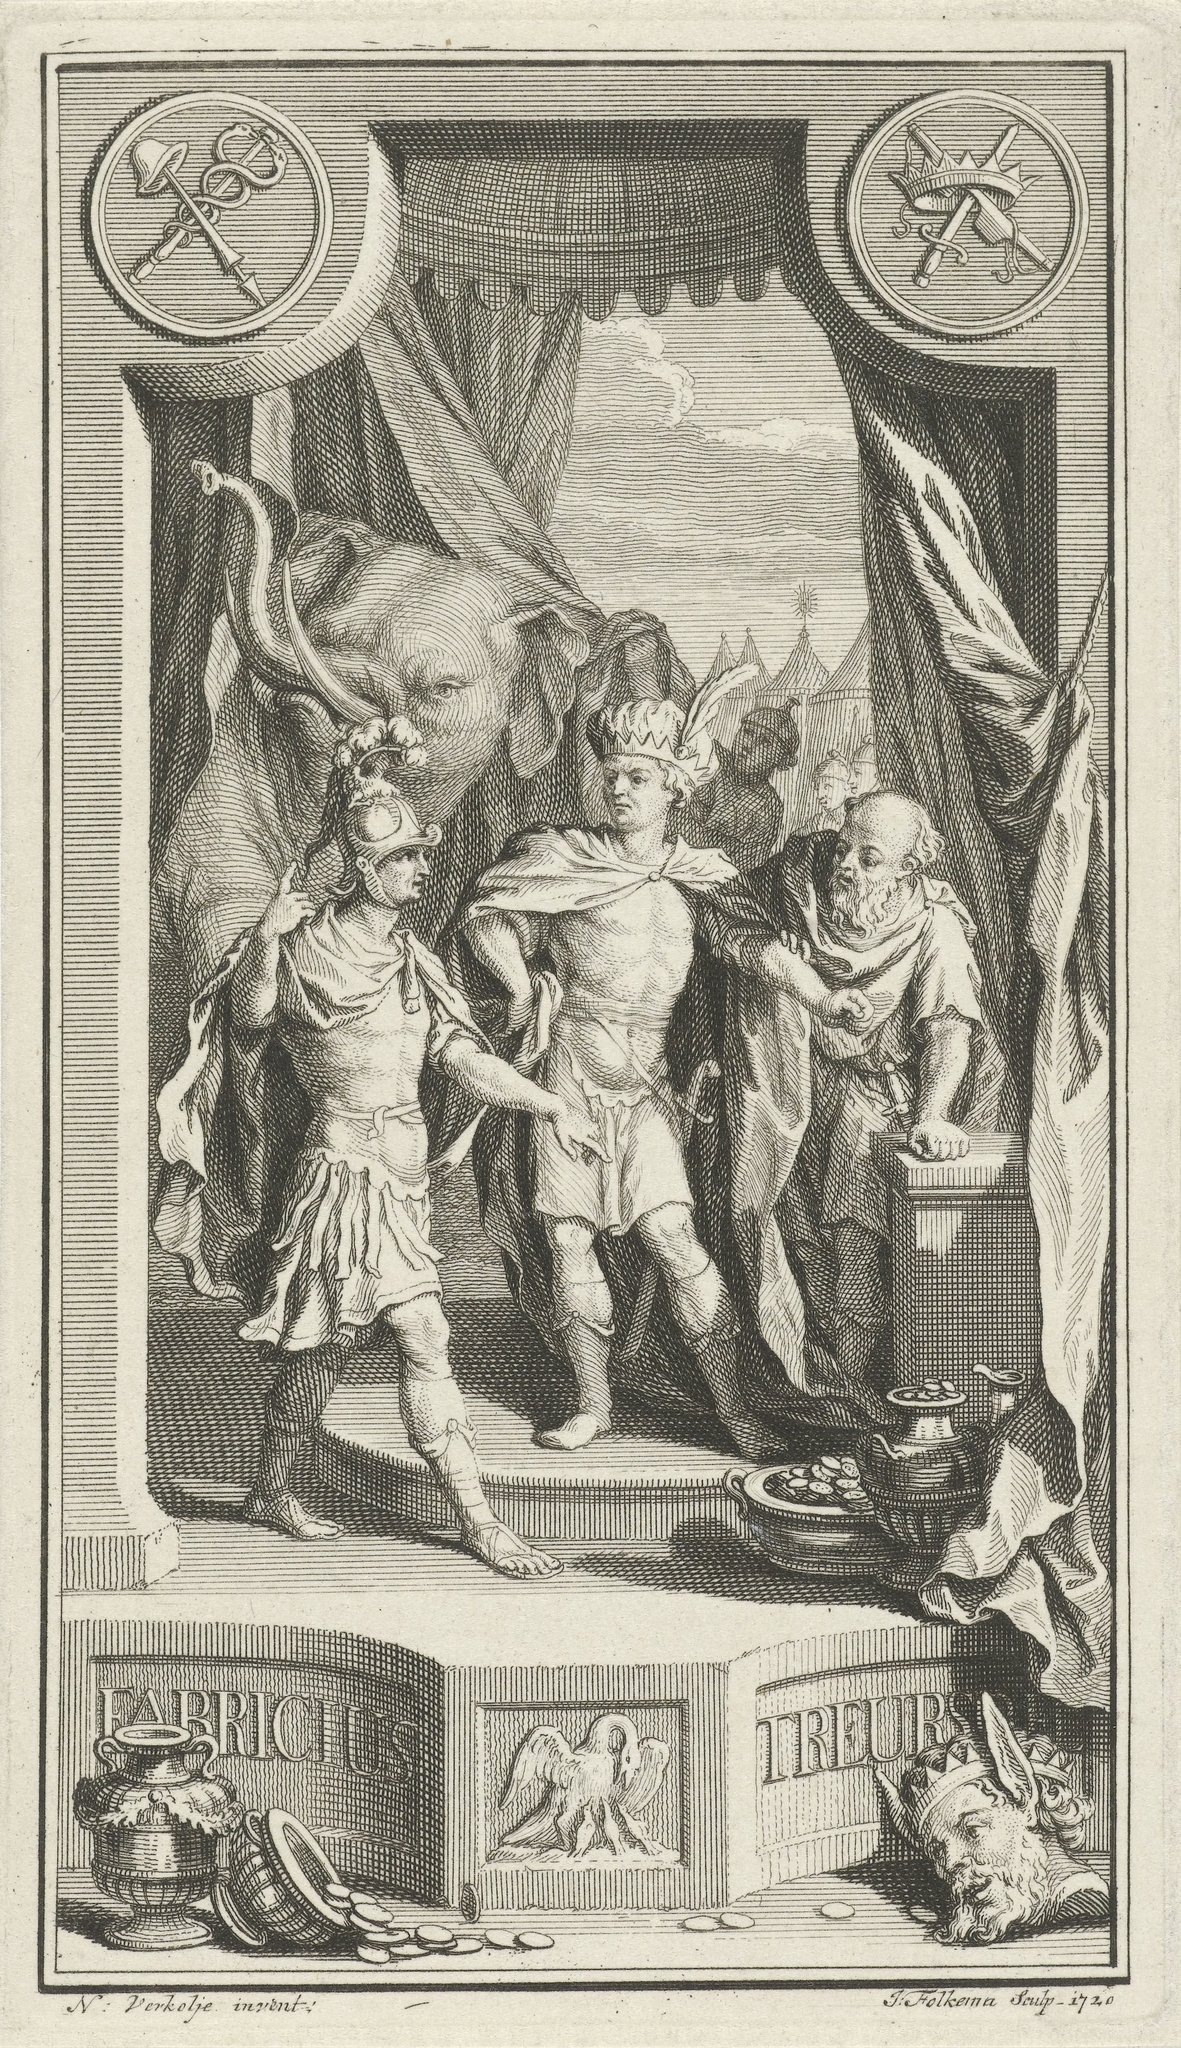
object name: print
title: Pyrrhus toont Gaius Fabricius Luscinus een olifant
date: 1720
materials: paper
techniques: etching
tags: trunked animals: elephant, c. fabricius refuses the gifts of pyrrhus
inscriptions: collector's mark: Lugt 240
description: De Romeinse consul Gaius Fabritius Luscinus bezoekt voor vredesonderhandelingen Koning Pyrrhus, met wie de Romeinen in oorlog waren. Pyrrhus staat centraal in het midden naast een oude man in toga en kijkt geërgerd naar Gaius Fabritius Luscinus. Phyrrus doet er alles aan om hem om te kopen, maar ook van de olifant die de tent binnen komt lopen is de Romeinse consul niet onder de indruk.